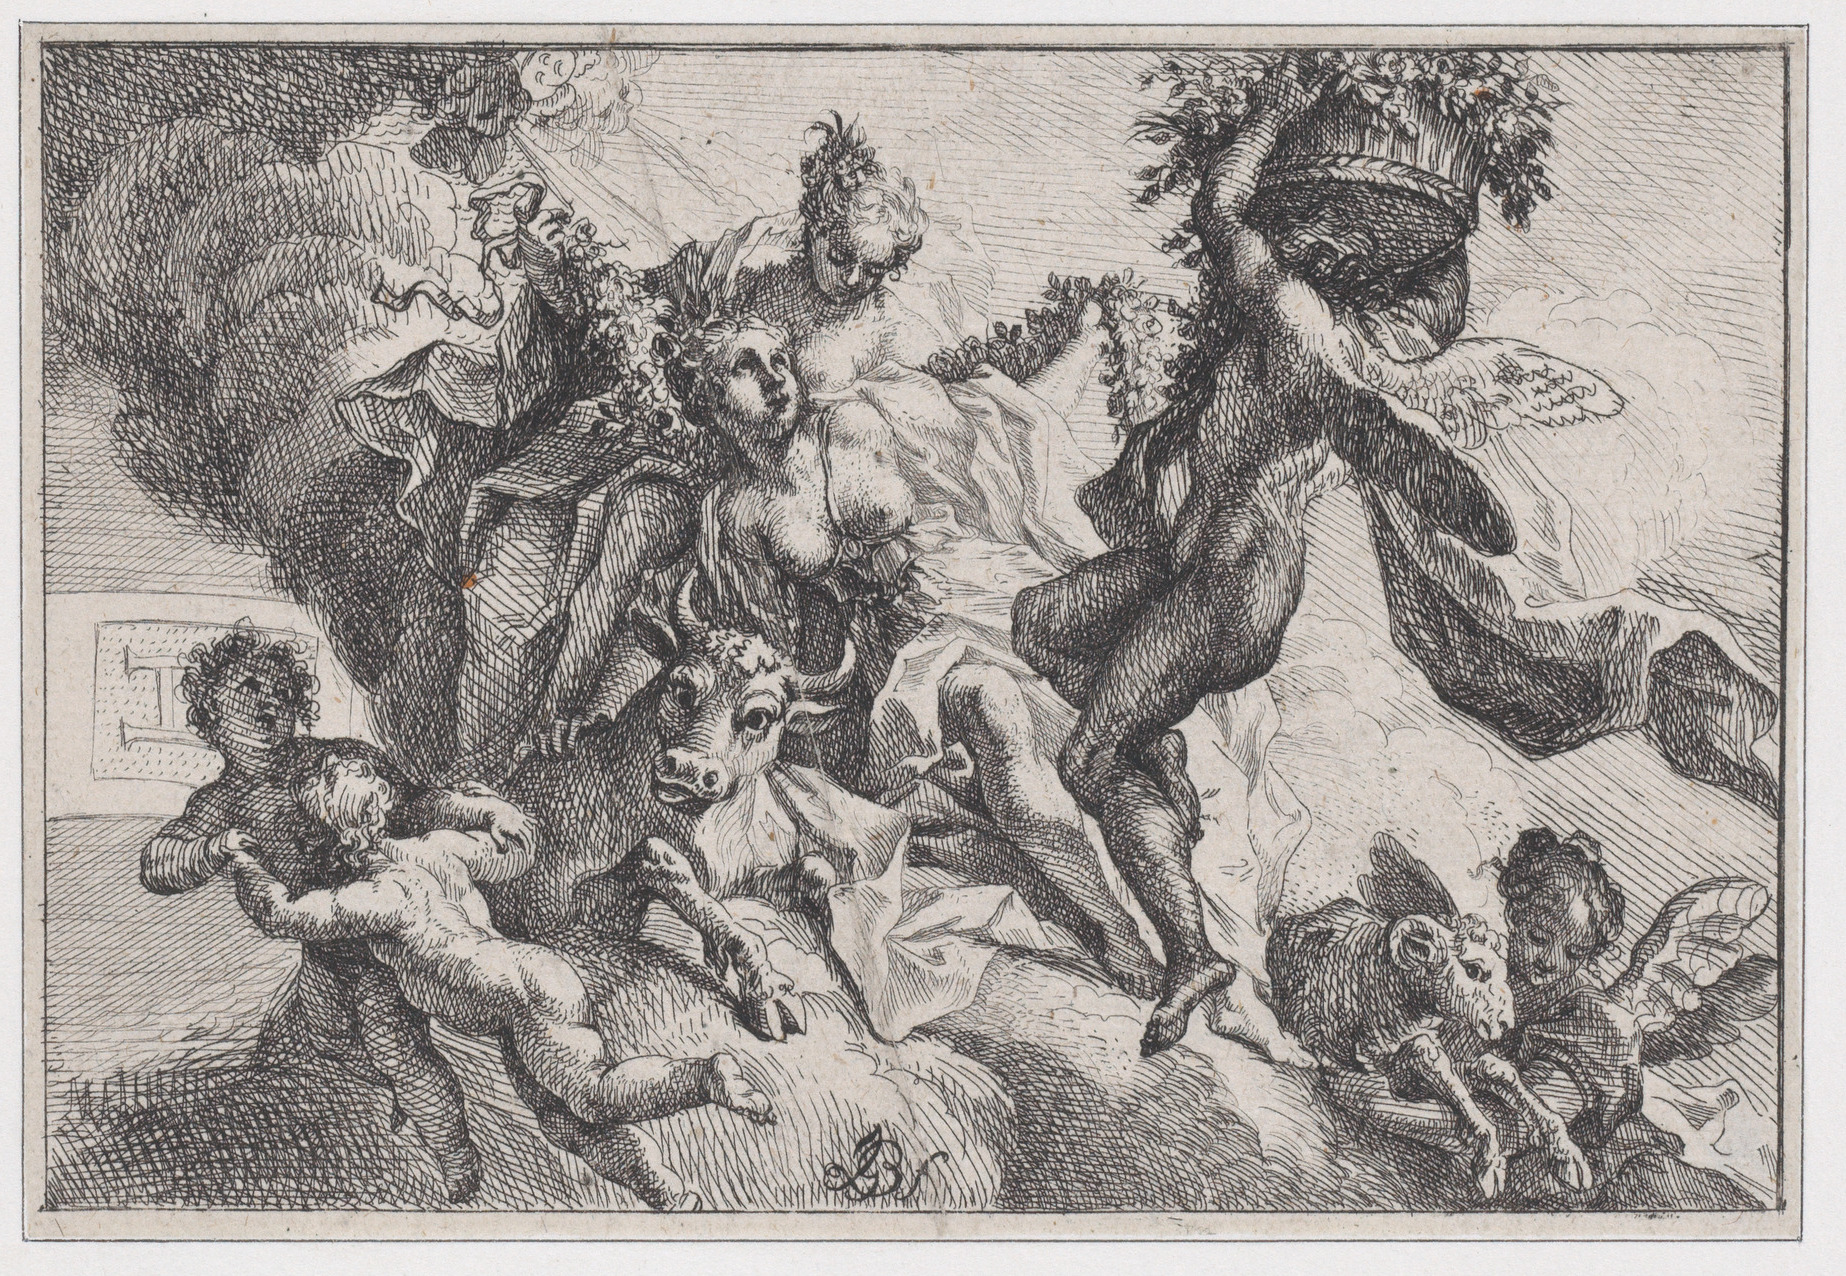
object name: print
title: Autumn: allegorical scene with figures seated on clouds with a bull and ram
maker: johann georg bergmüller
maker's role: artist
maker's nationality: german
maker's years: 1688-1762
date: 1710-1762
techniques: etching